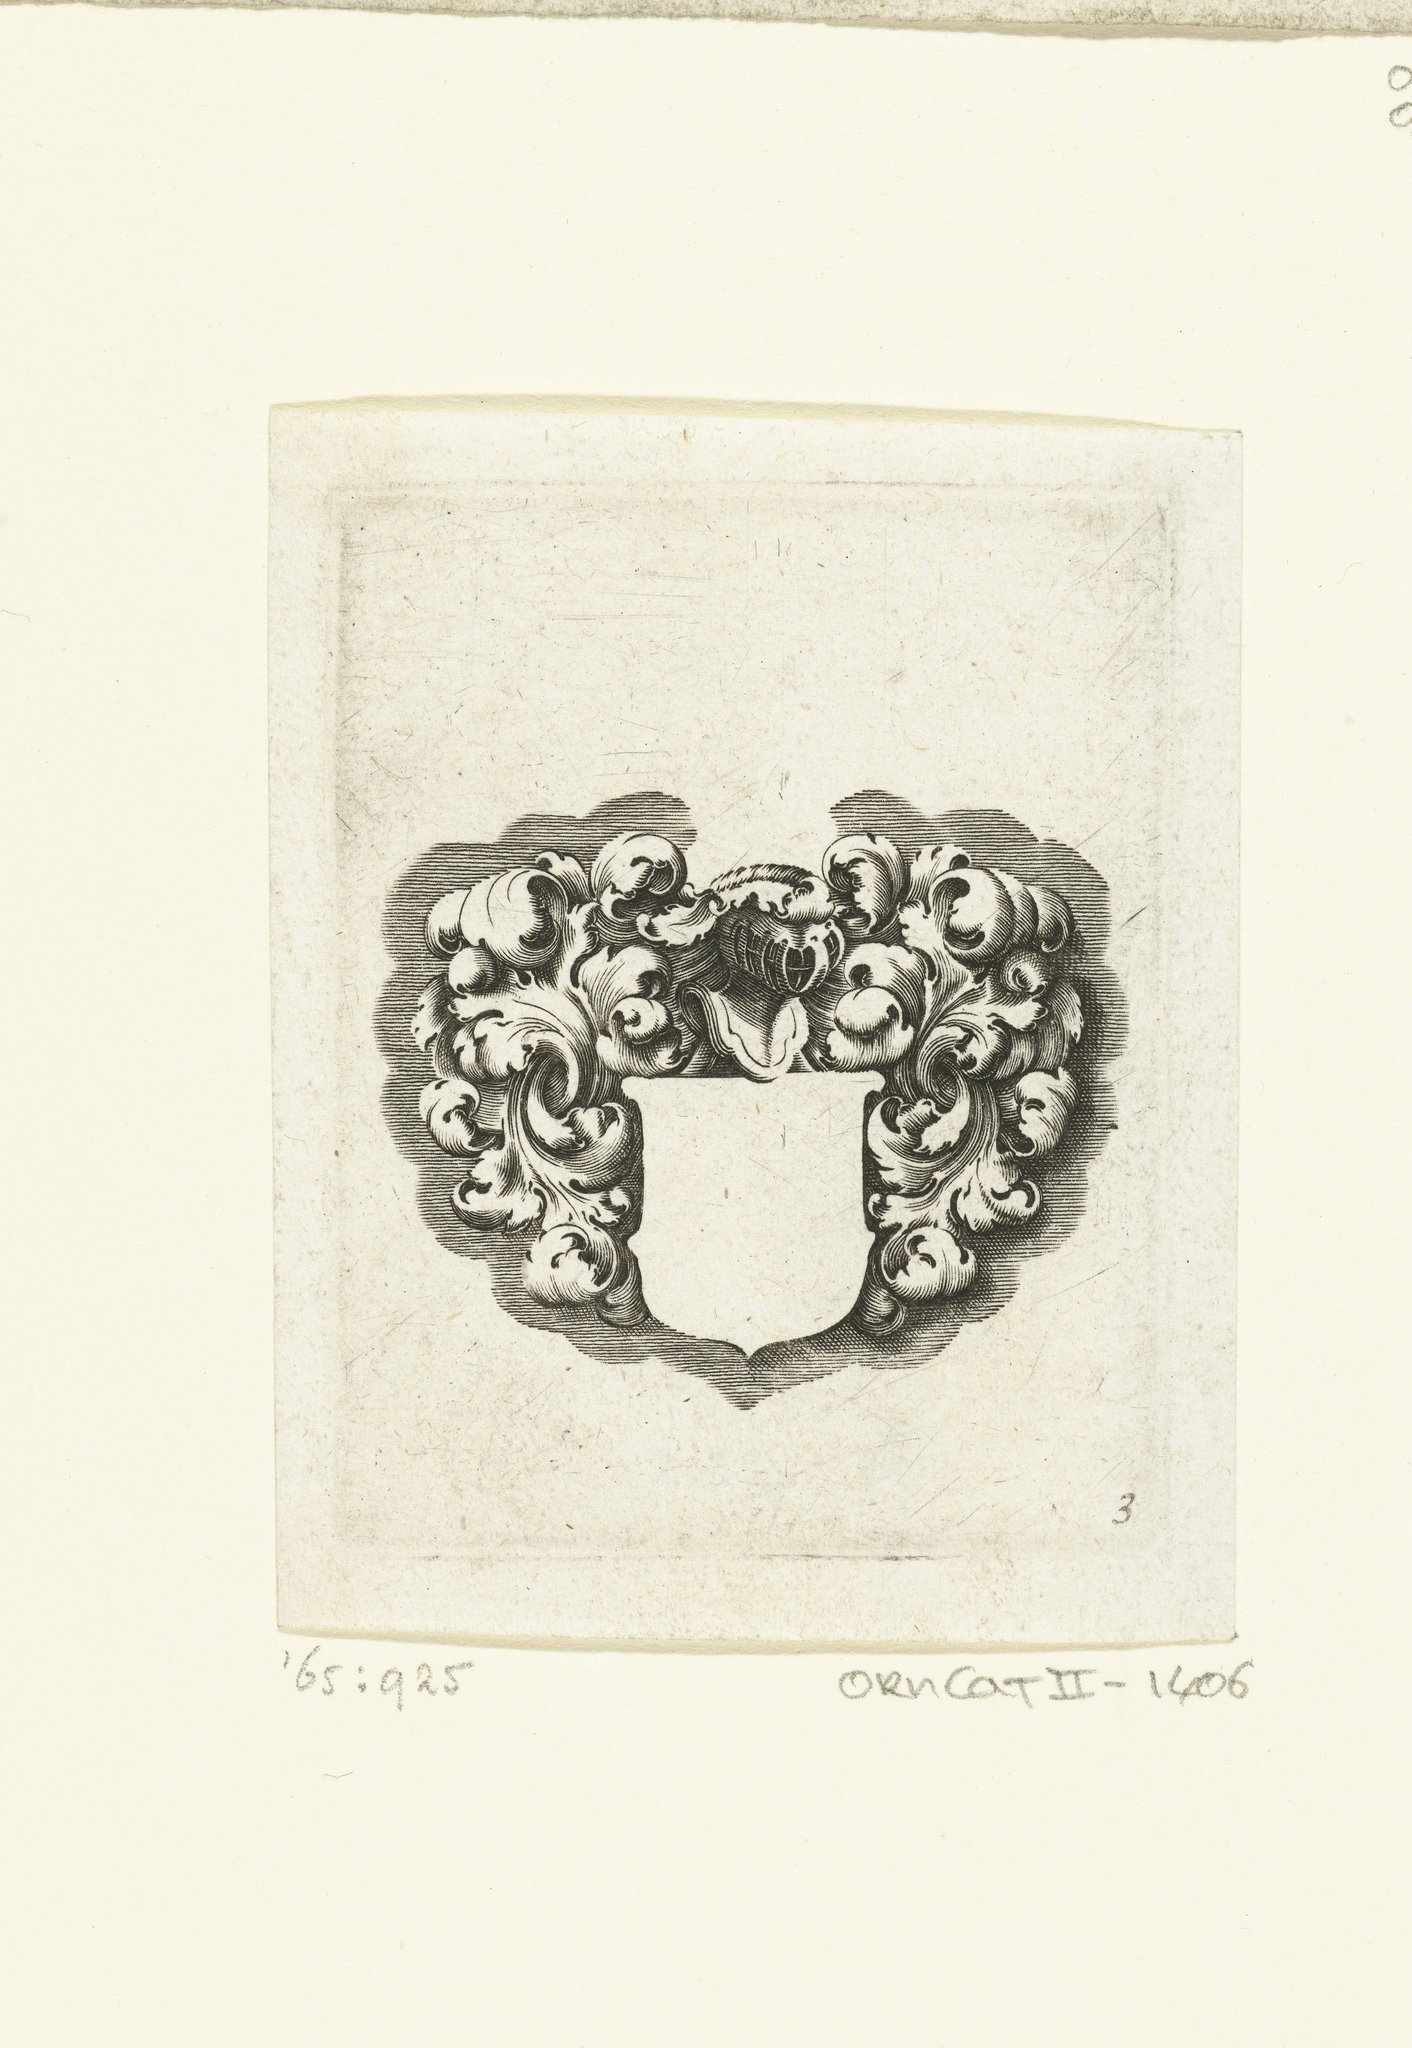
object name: ornament print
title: Wapenschild met leeg veld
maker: Anonymous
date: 1611-1625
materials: paper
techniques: engraving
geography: amsterdam